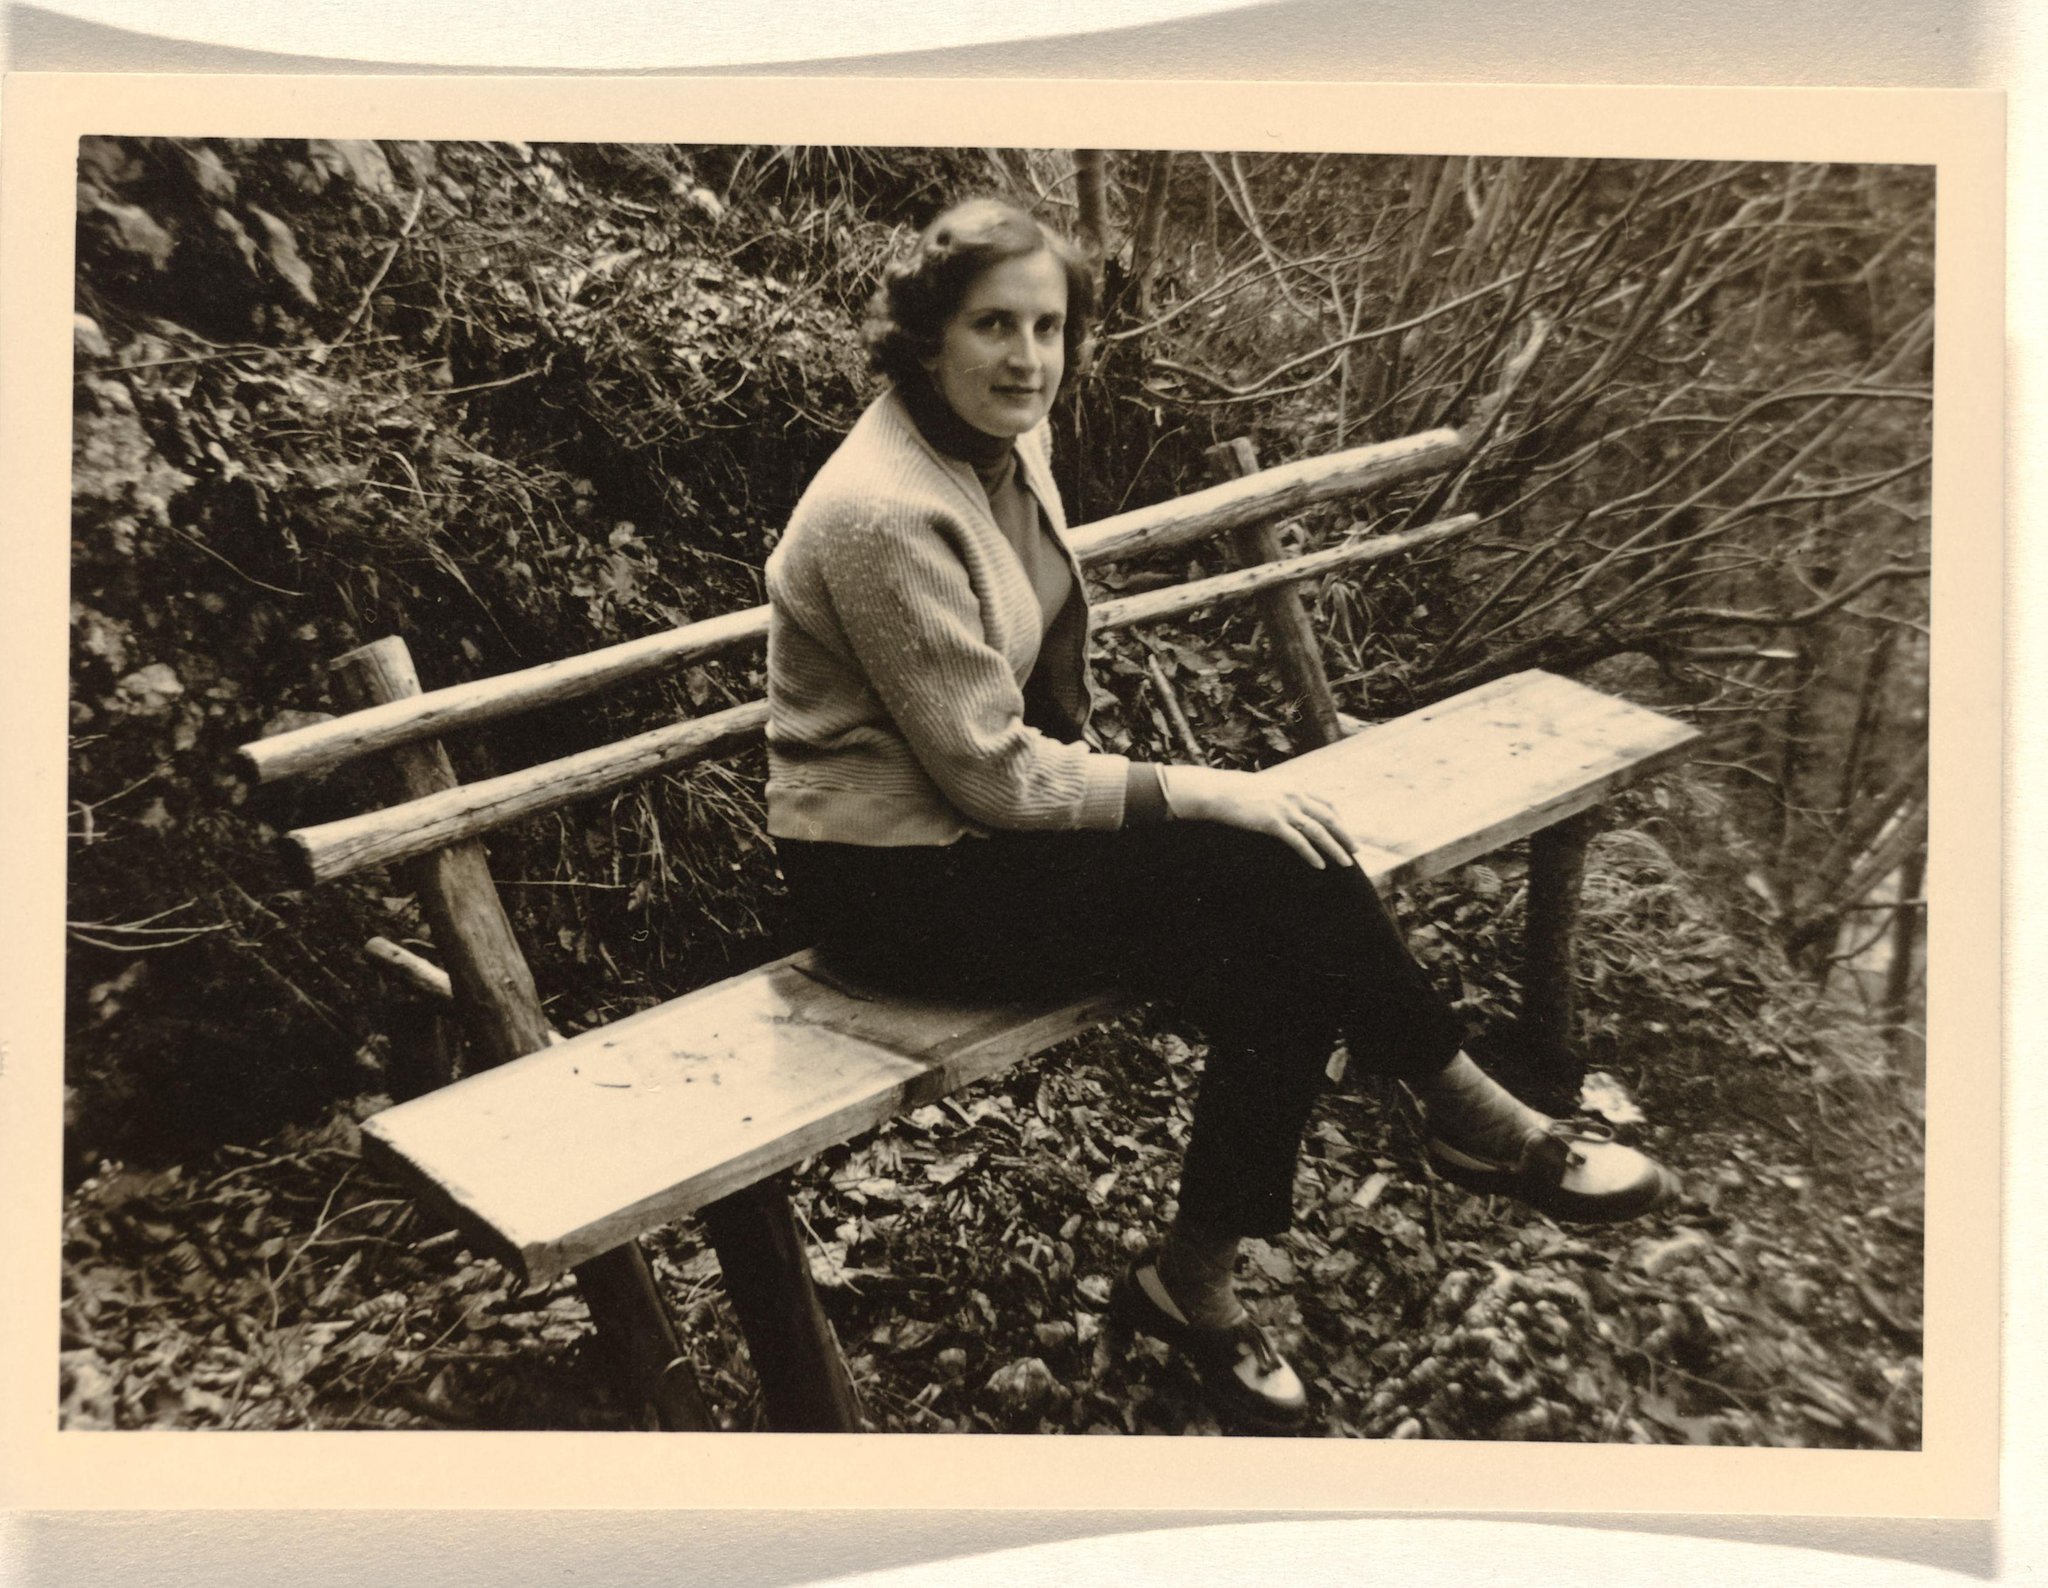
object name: photograph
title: Isabel Wachenheimer gezeten op een bankje met haar rechterhand op haar knie, voor ontbladerde bomen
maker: Anonymous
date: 1956-1973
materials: photographic support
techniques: gelatin silver print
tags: isabel wachenheimer-elon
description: Isabel Wachenheimer gezeten op een bankje met haar rechterhand op haar knie, voor ontbladerde bomen.